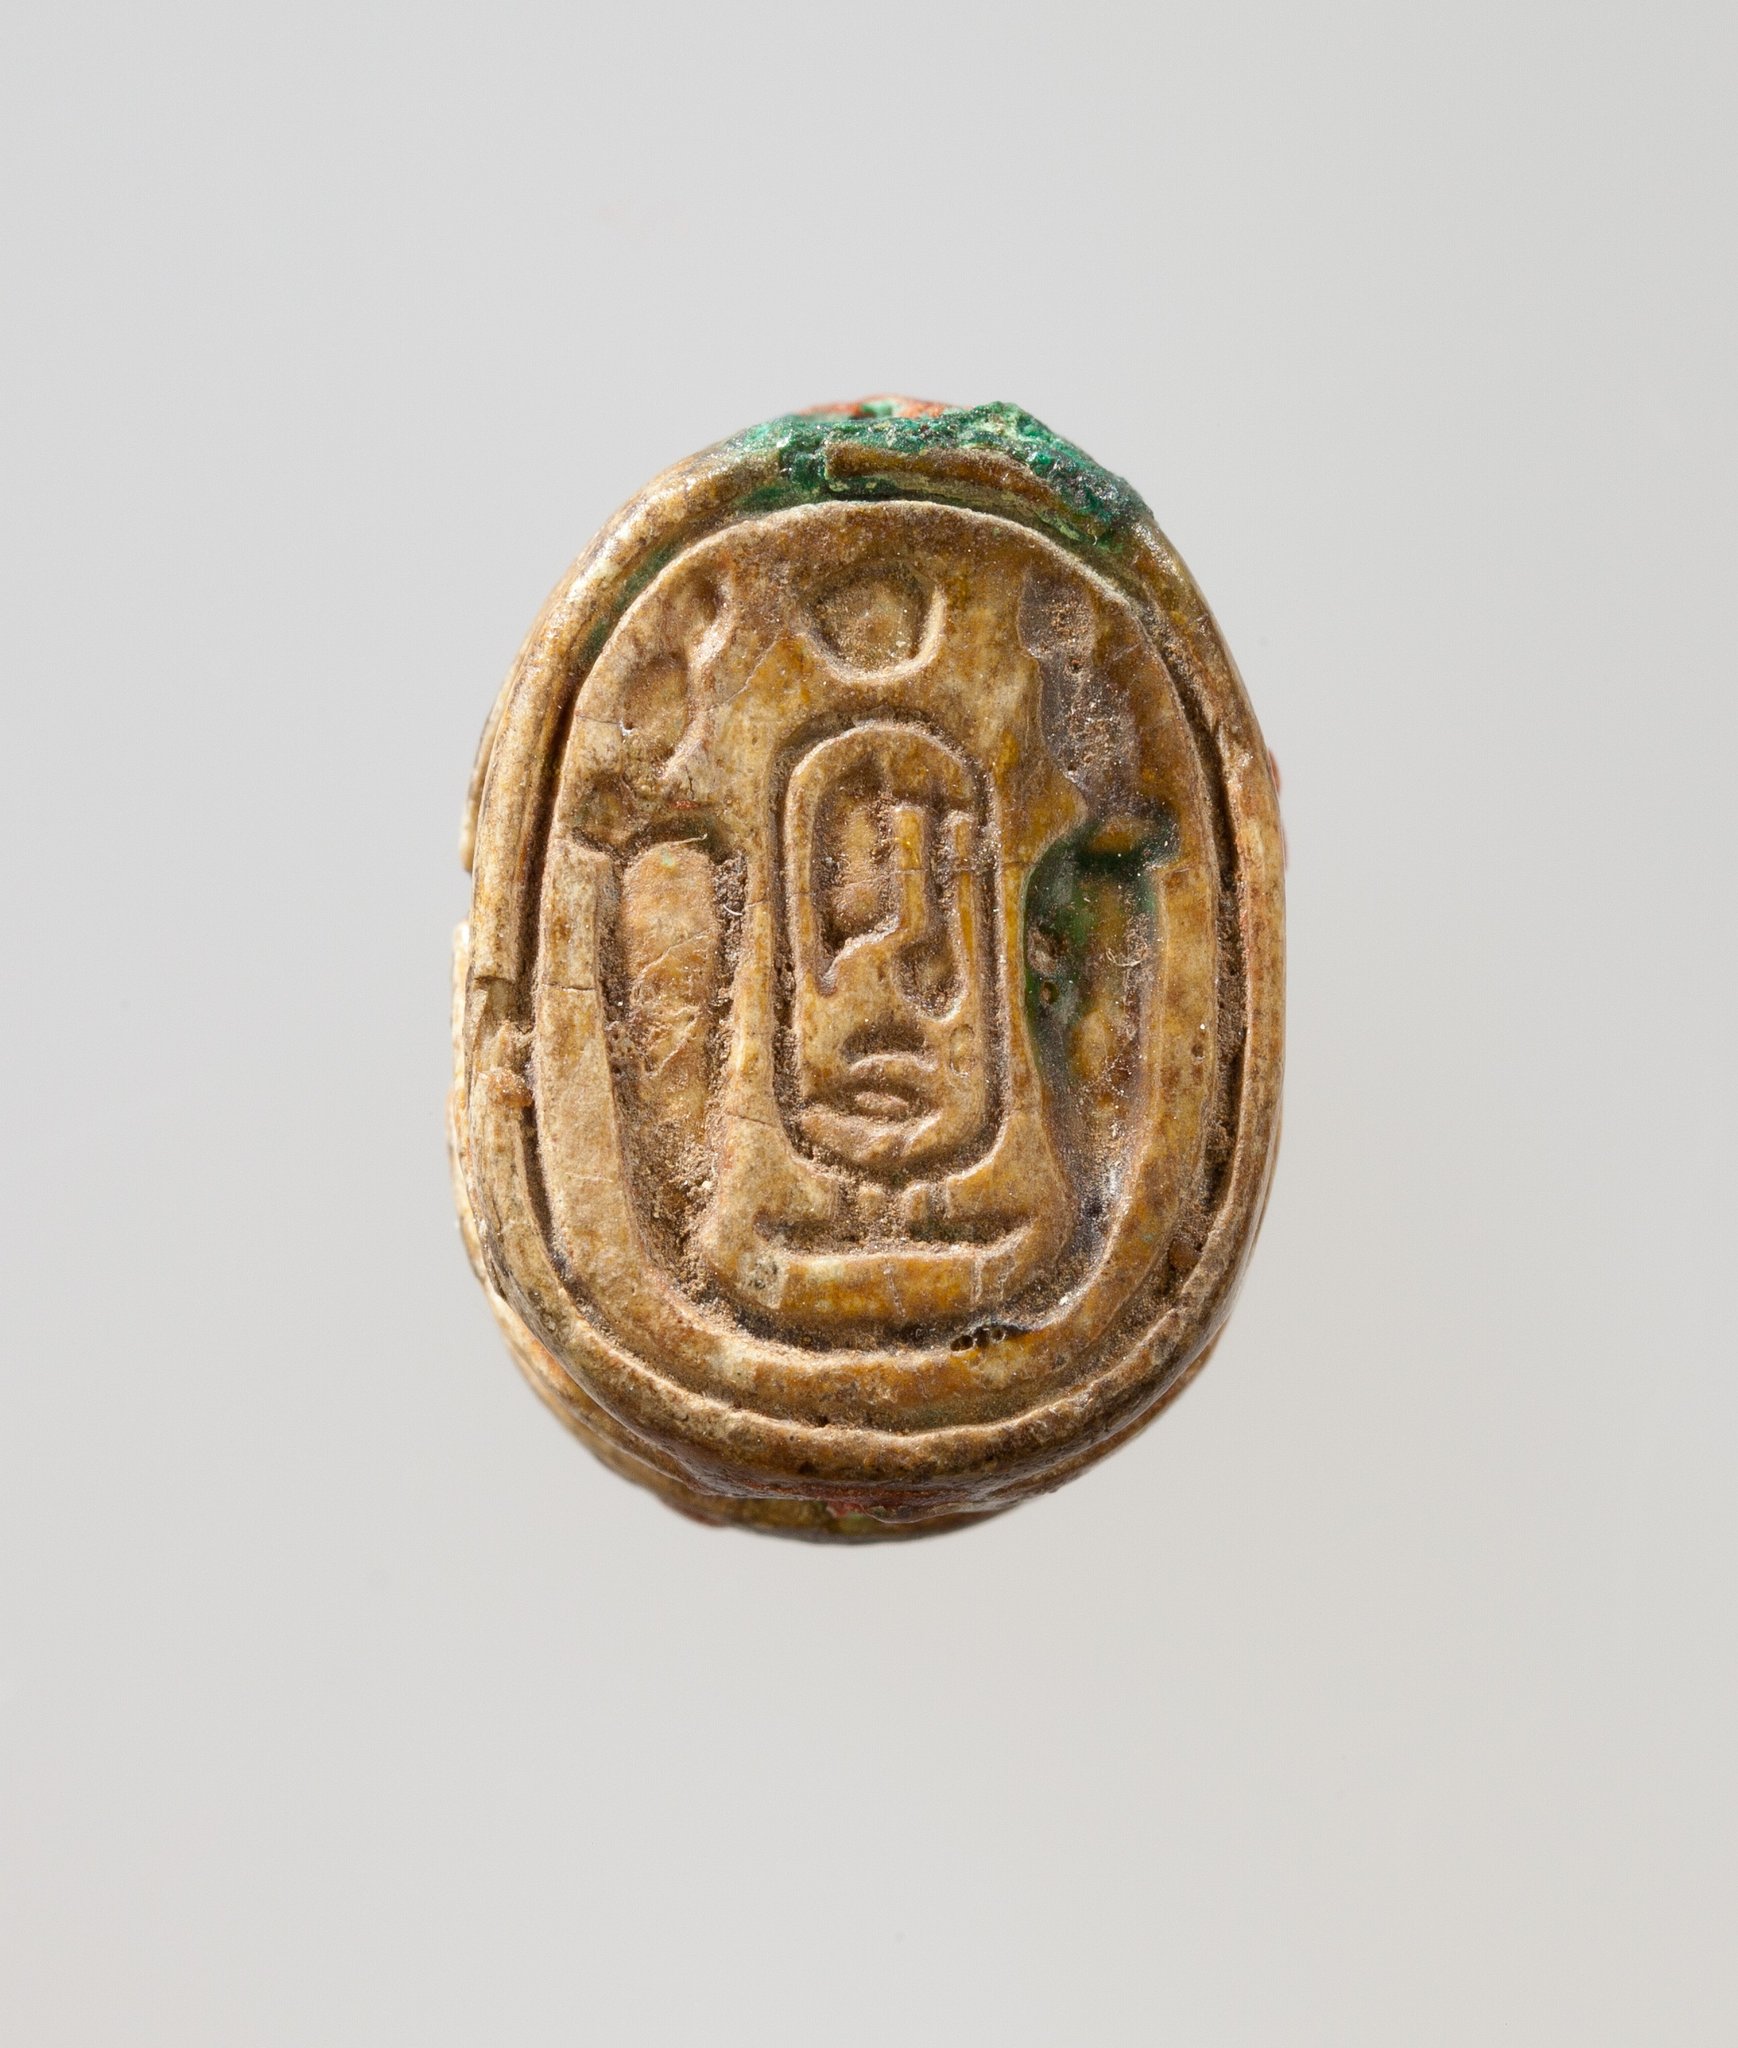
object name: scarab, ahmose nefertari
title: Scarab Inscribed for Ahmose-Nefertari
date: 1550-1525 BCE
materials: stone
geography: egypt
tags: hieroglyphs,scarabs